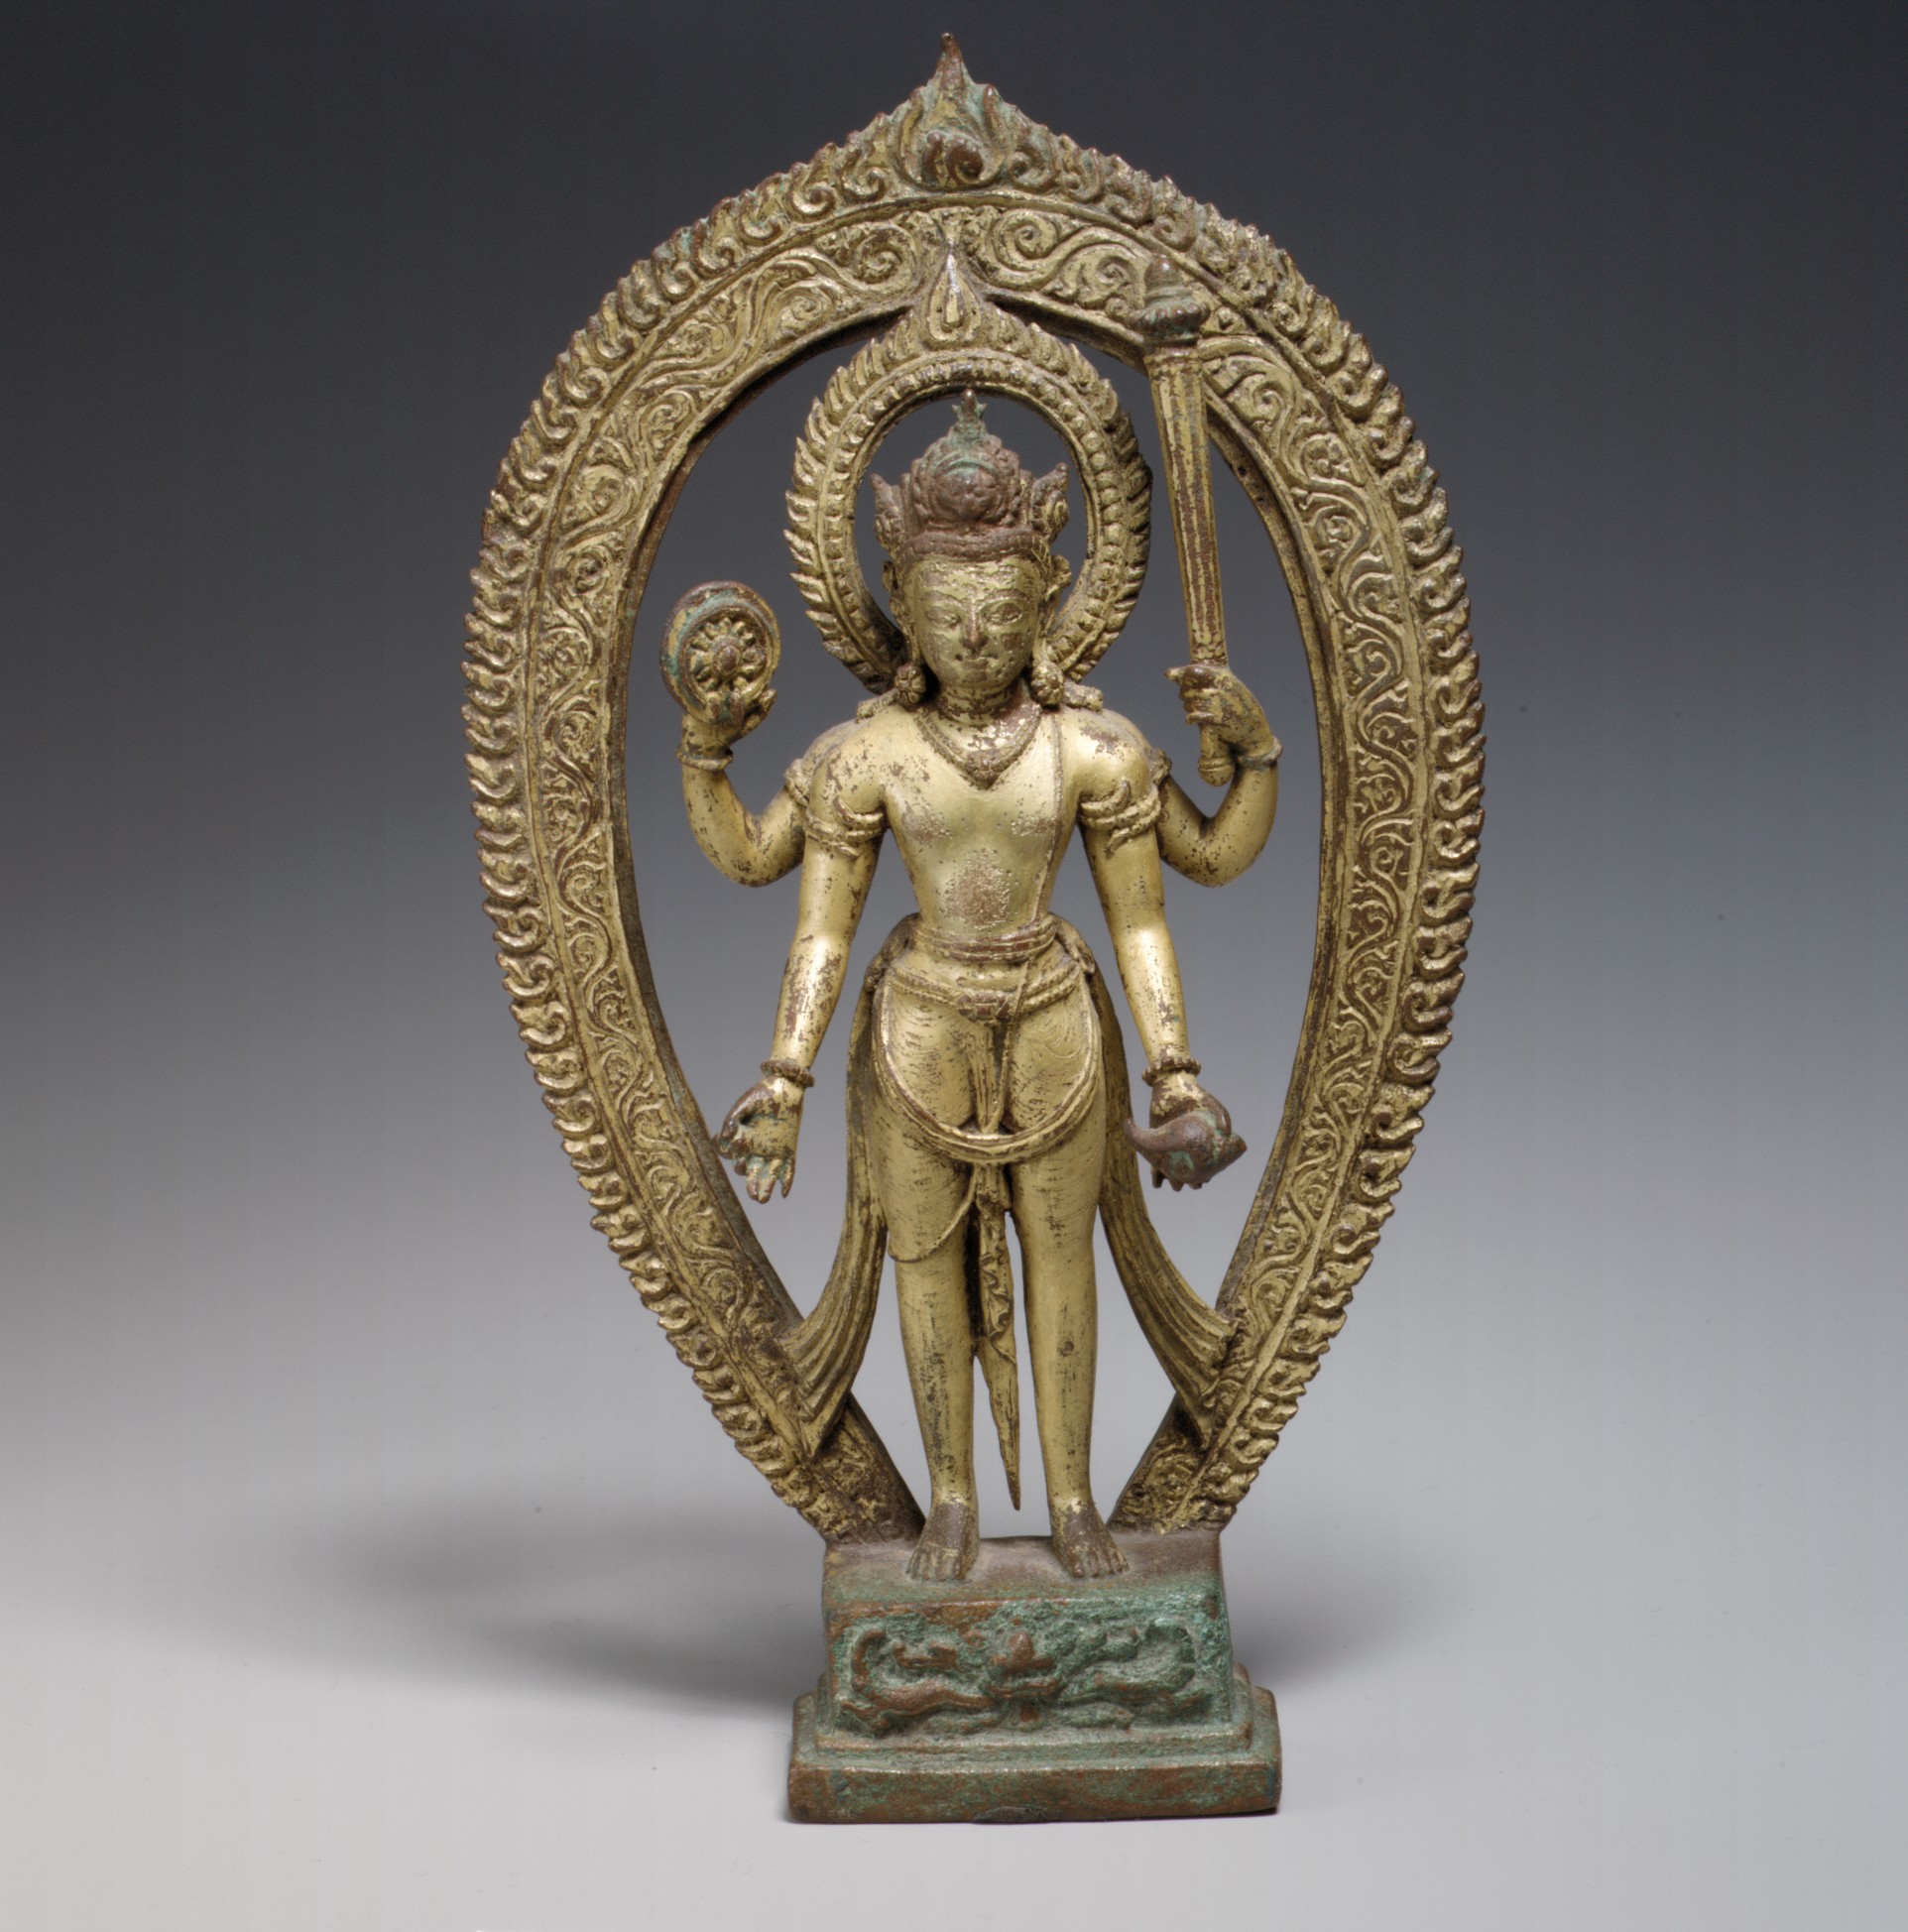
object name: figure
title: Vishnu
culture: nepali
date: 901-1100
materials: copper alloy, gilt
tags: vishnu